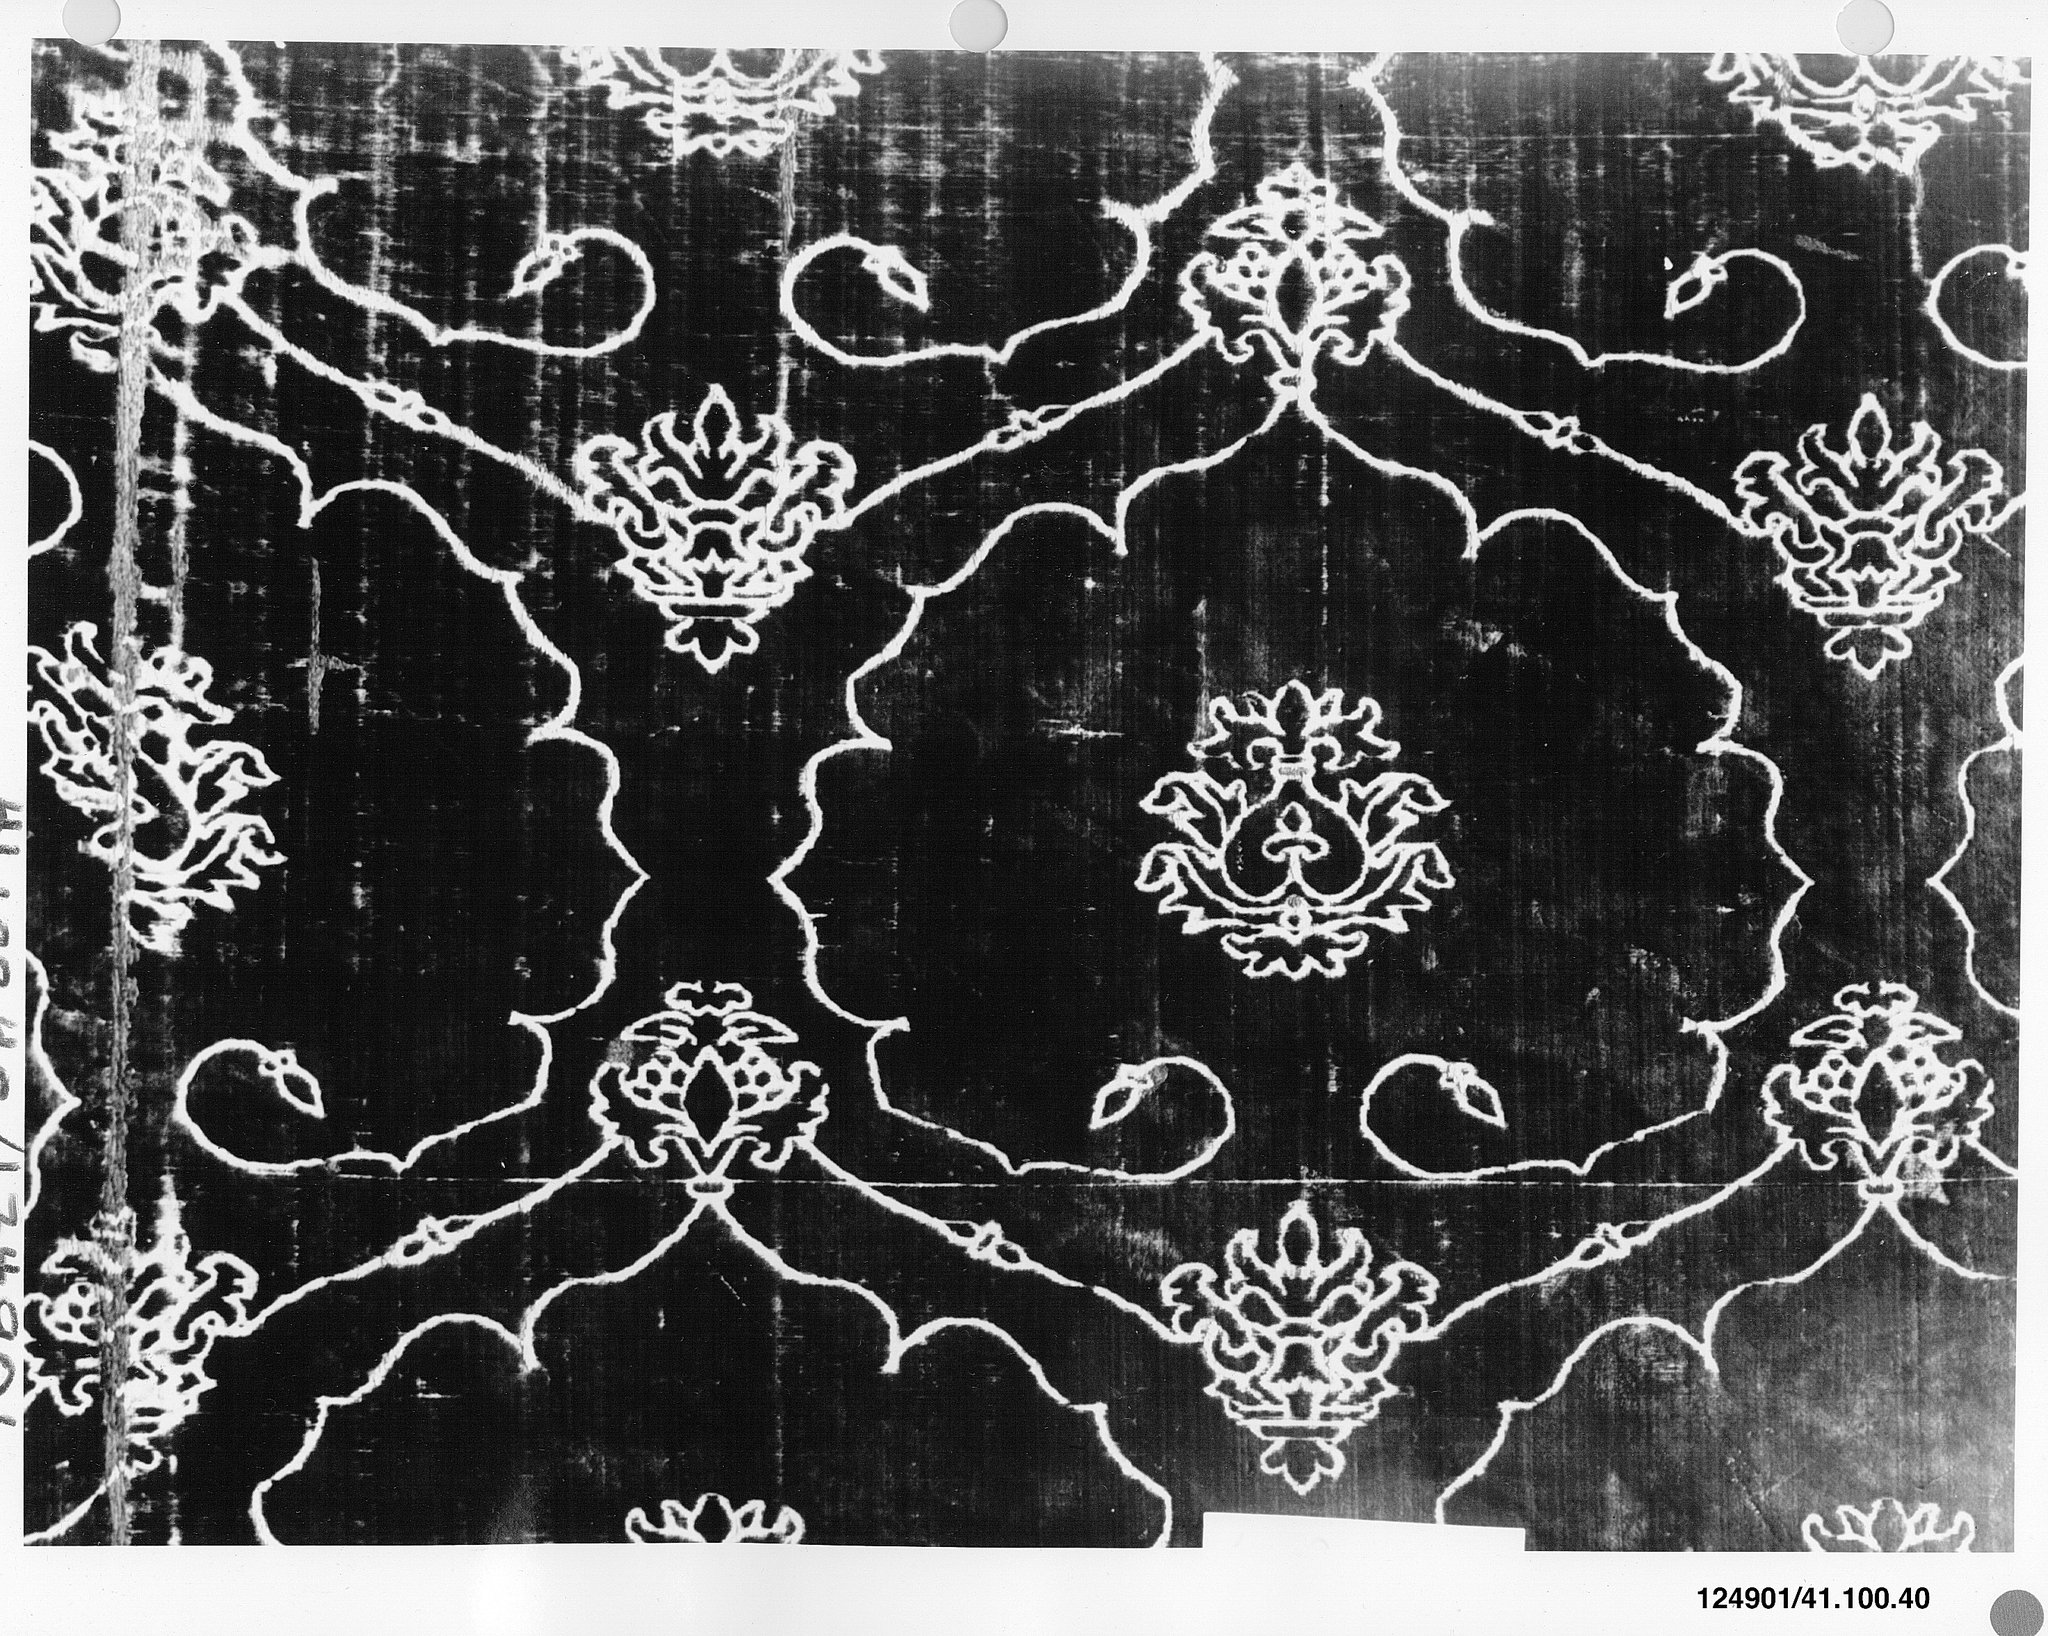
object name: cope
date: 1401-1500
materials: velvet